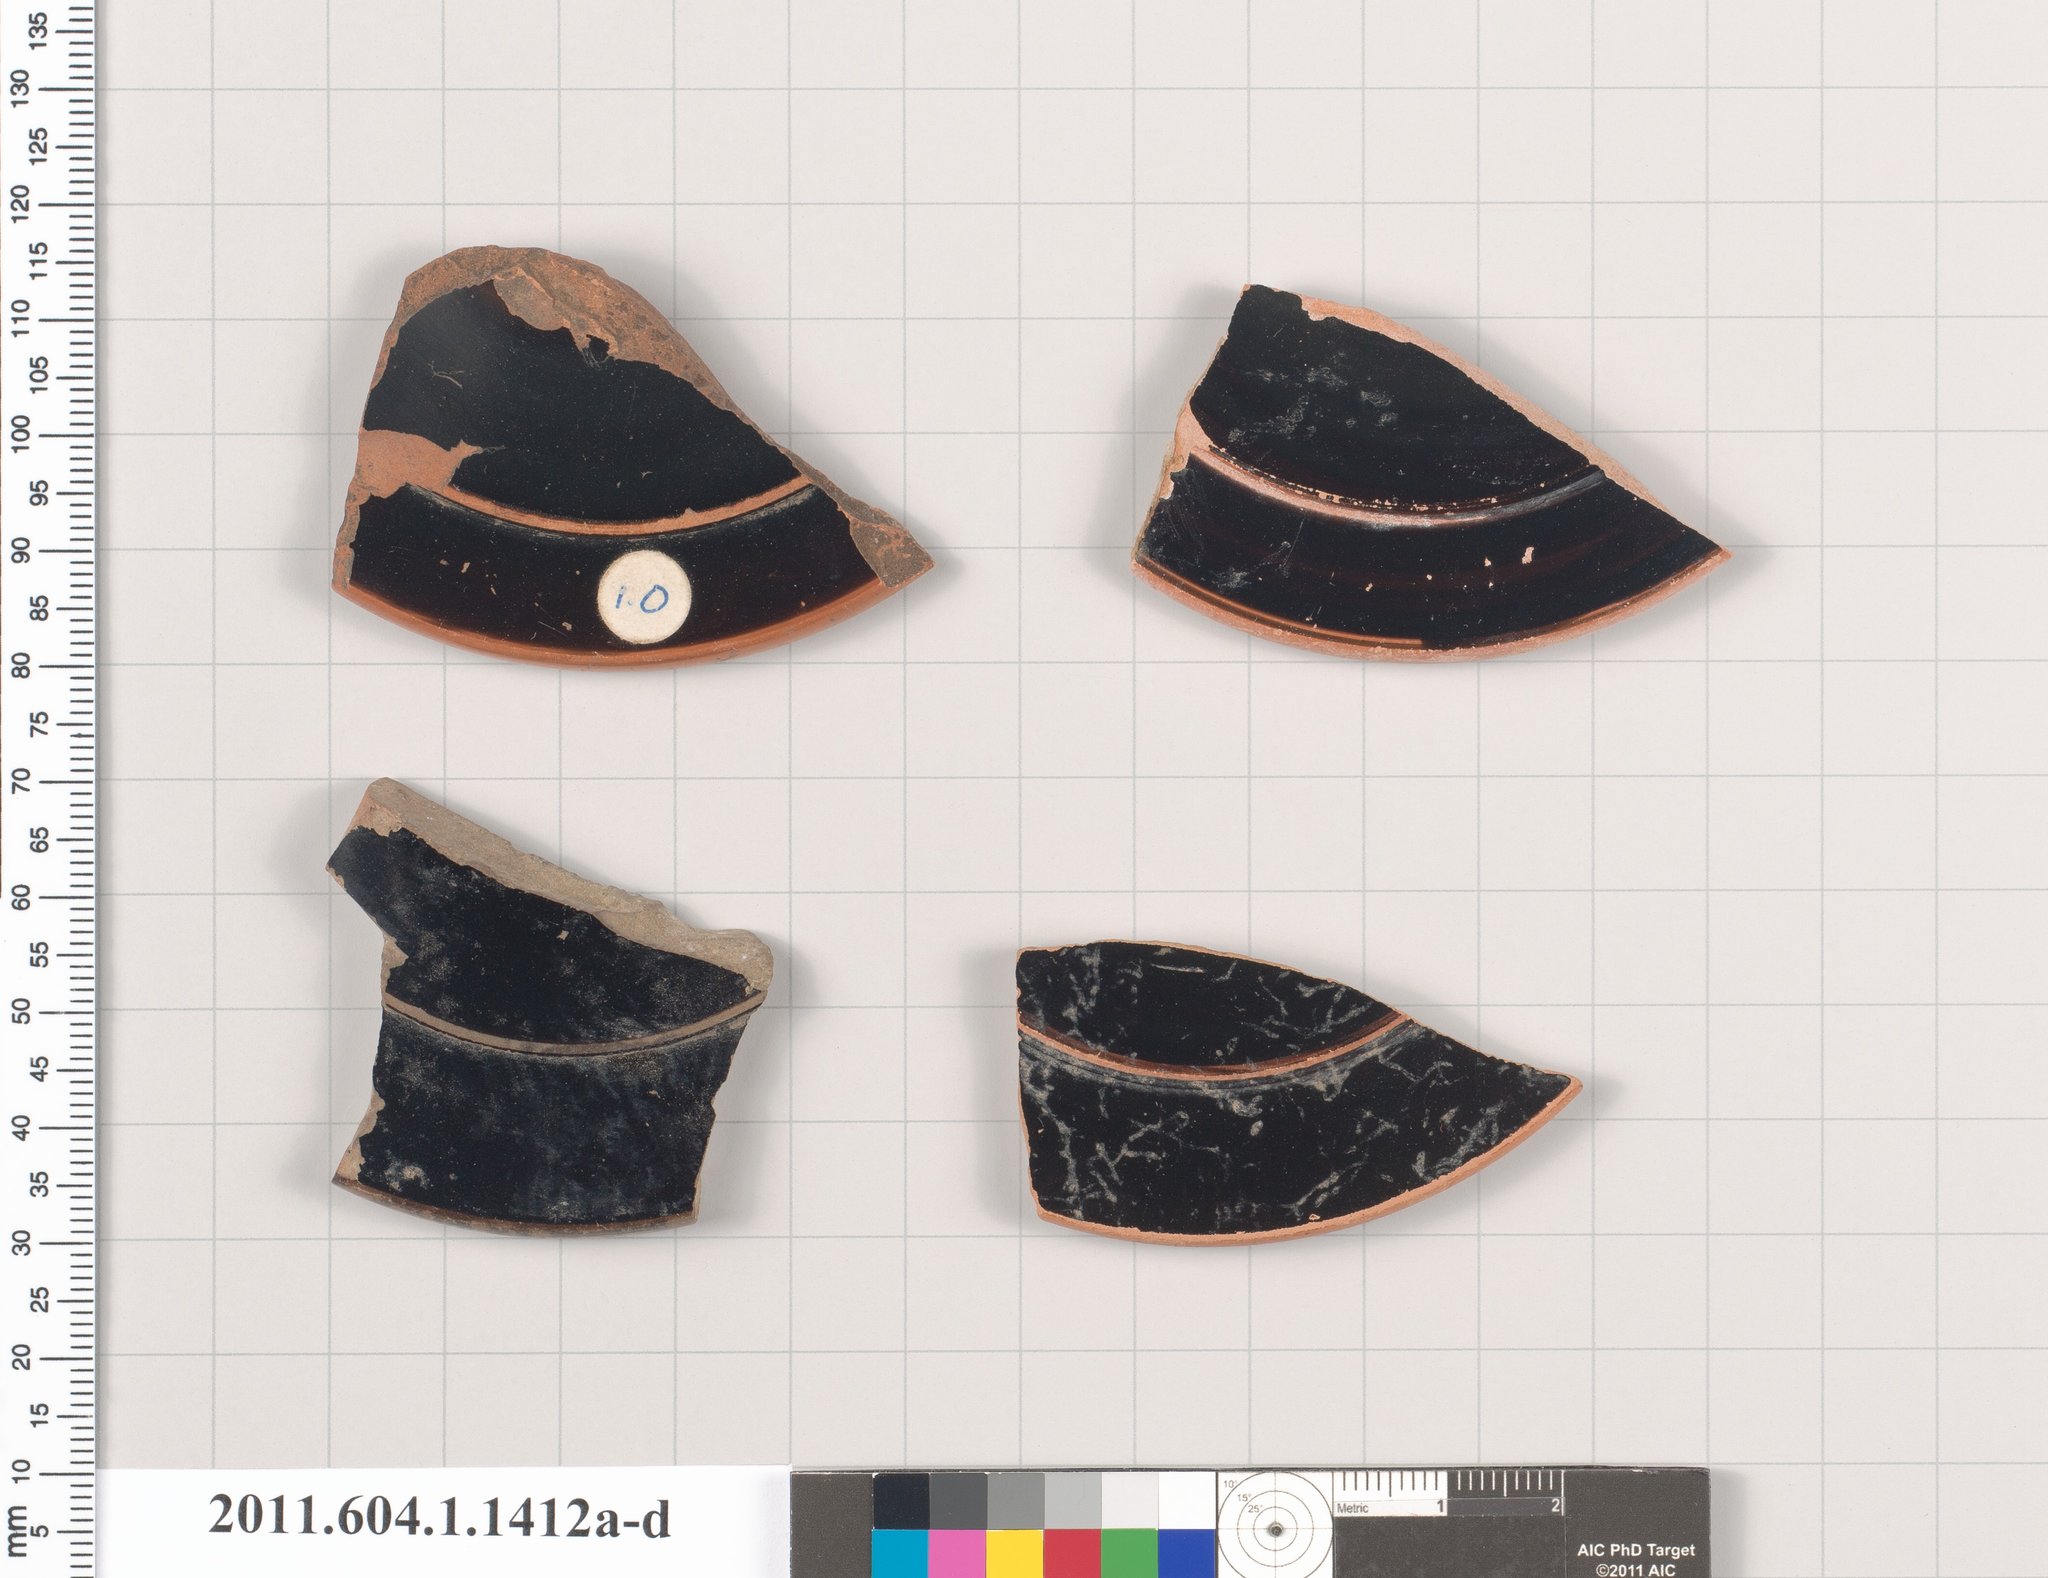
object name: kylix fragment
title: Terracotta fragments of kylikes (drinking cups)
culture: greek, attic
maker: brygan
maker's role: artist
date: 500-401 BCE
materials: terracotta